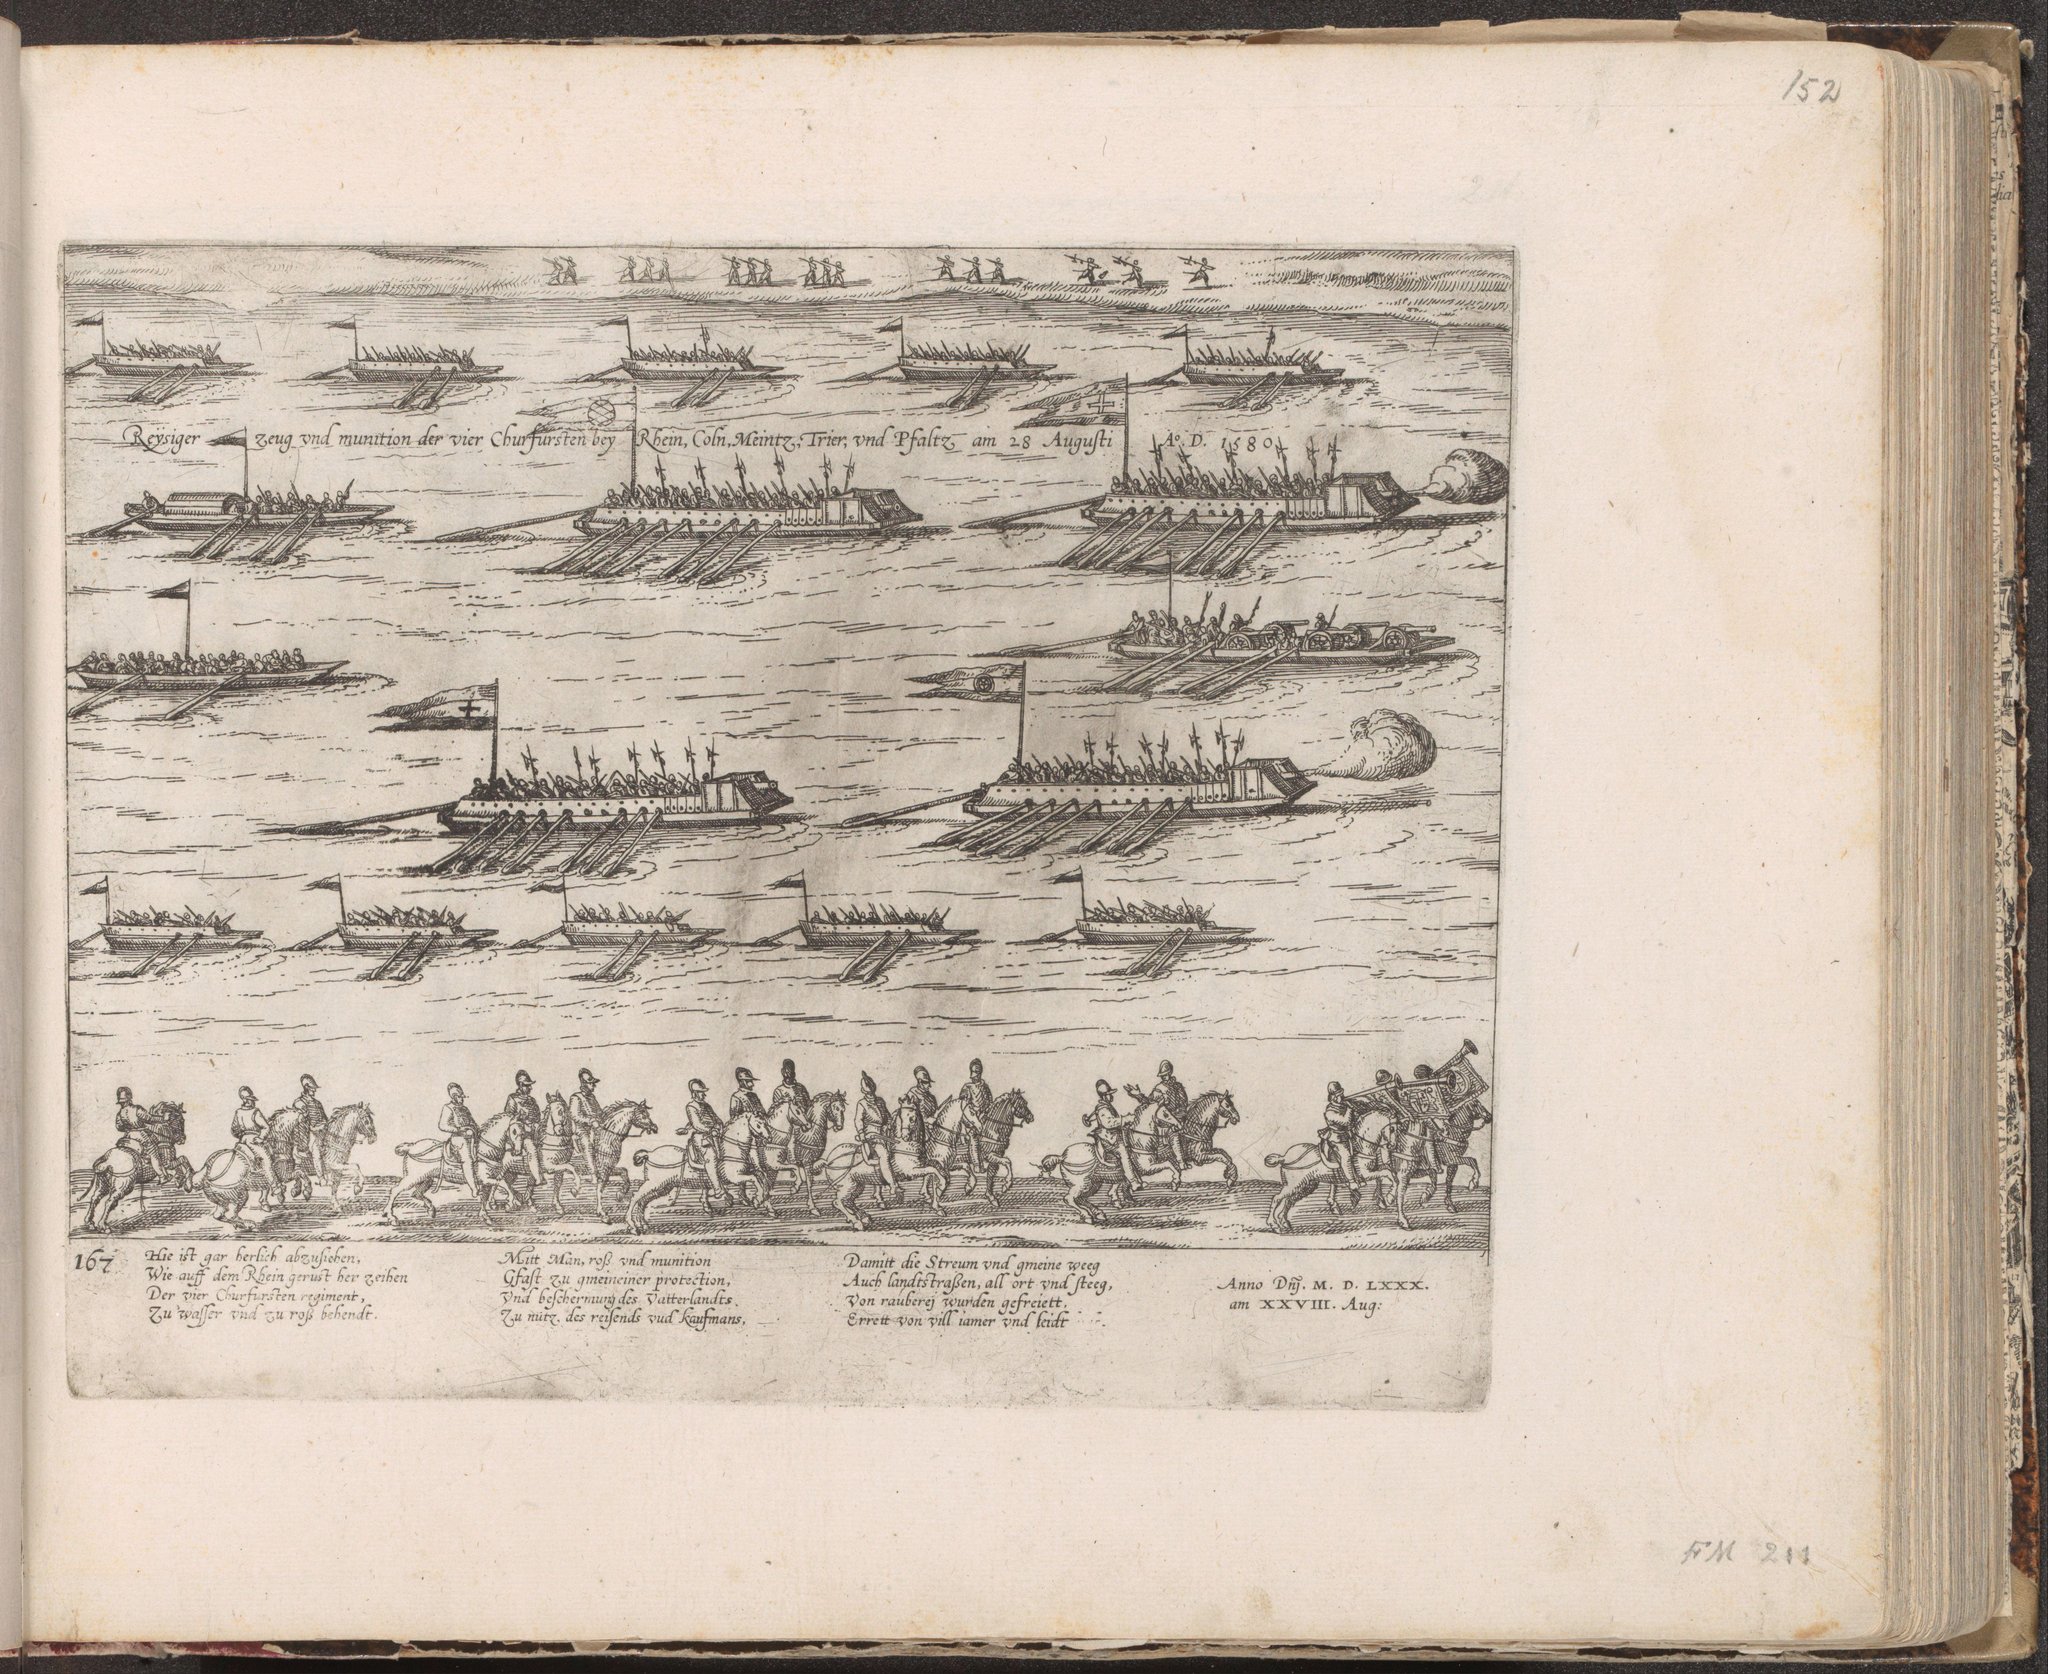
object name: print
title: Reysiger zeug und munition der vier Churfursten bey Rhein, Coln, Meintz, Trier, und Pfaltz am 28 Augusti Ao. D. 1580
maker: frans hogenberg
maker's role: print maker, publisher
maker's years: 1538-1590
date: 1581-1585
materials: paper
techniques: etching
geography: cologne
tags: warfare; military affairs (+ oared ships, e.g.: galley)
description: Vloot van bewapende galeien en andere roeivaartuigen van de vier Duitse keurvorsten op de Rijn. Ruiters op de oever. Met onderschrift van 12 regels in het Duits. Linksonder genummerd: 167. De prent maakt deel uit van een album.